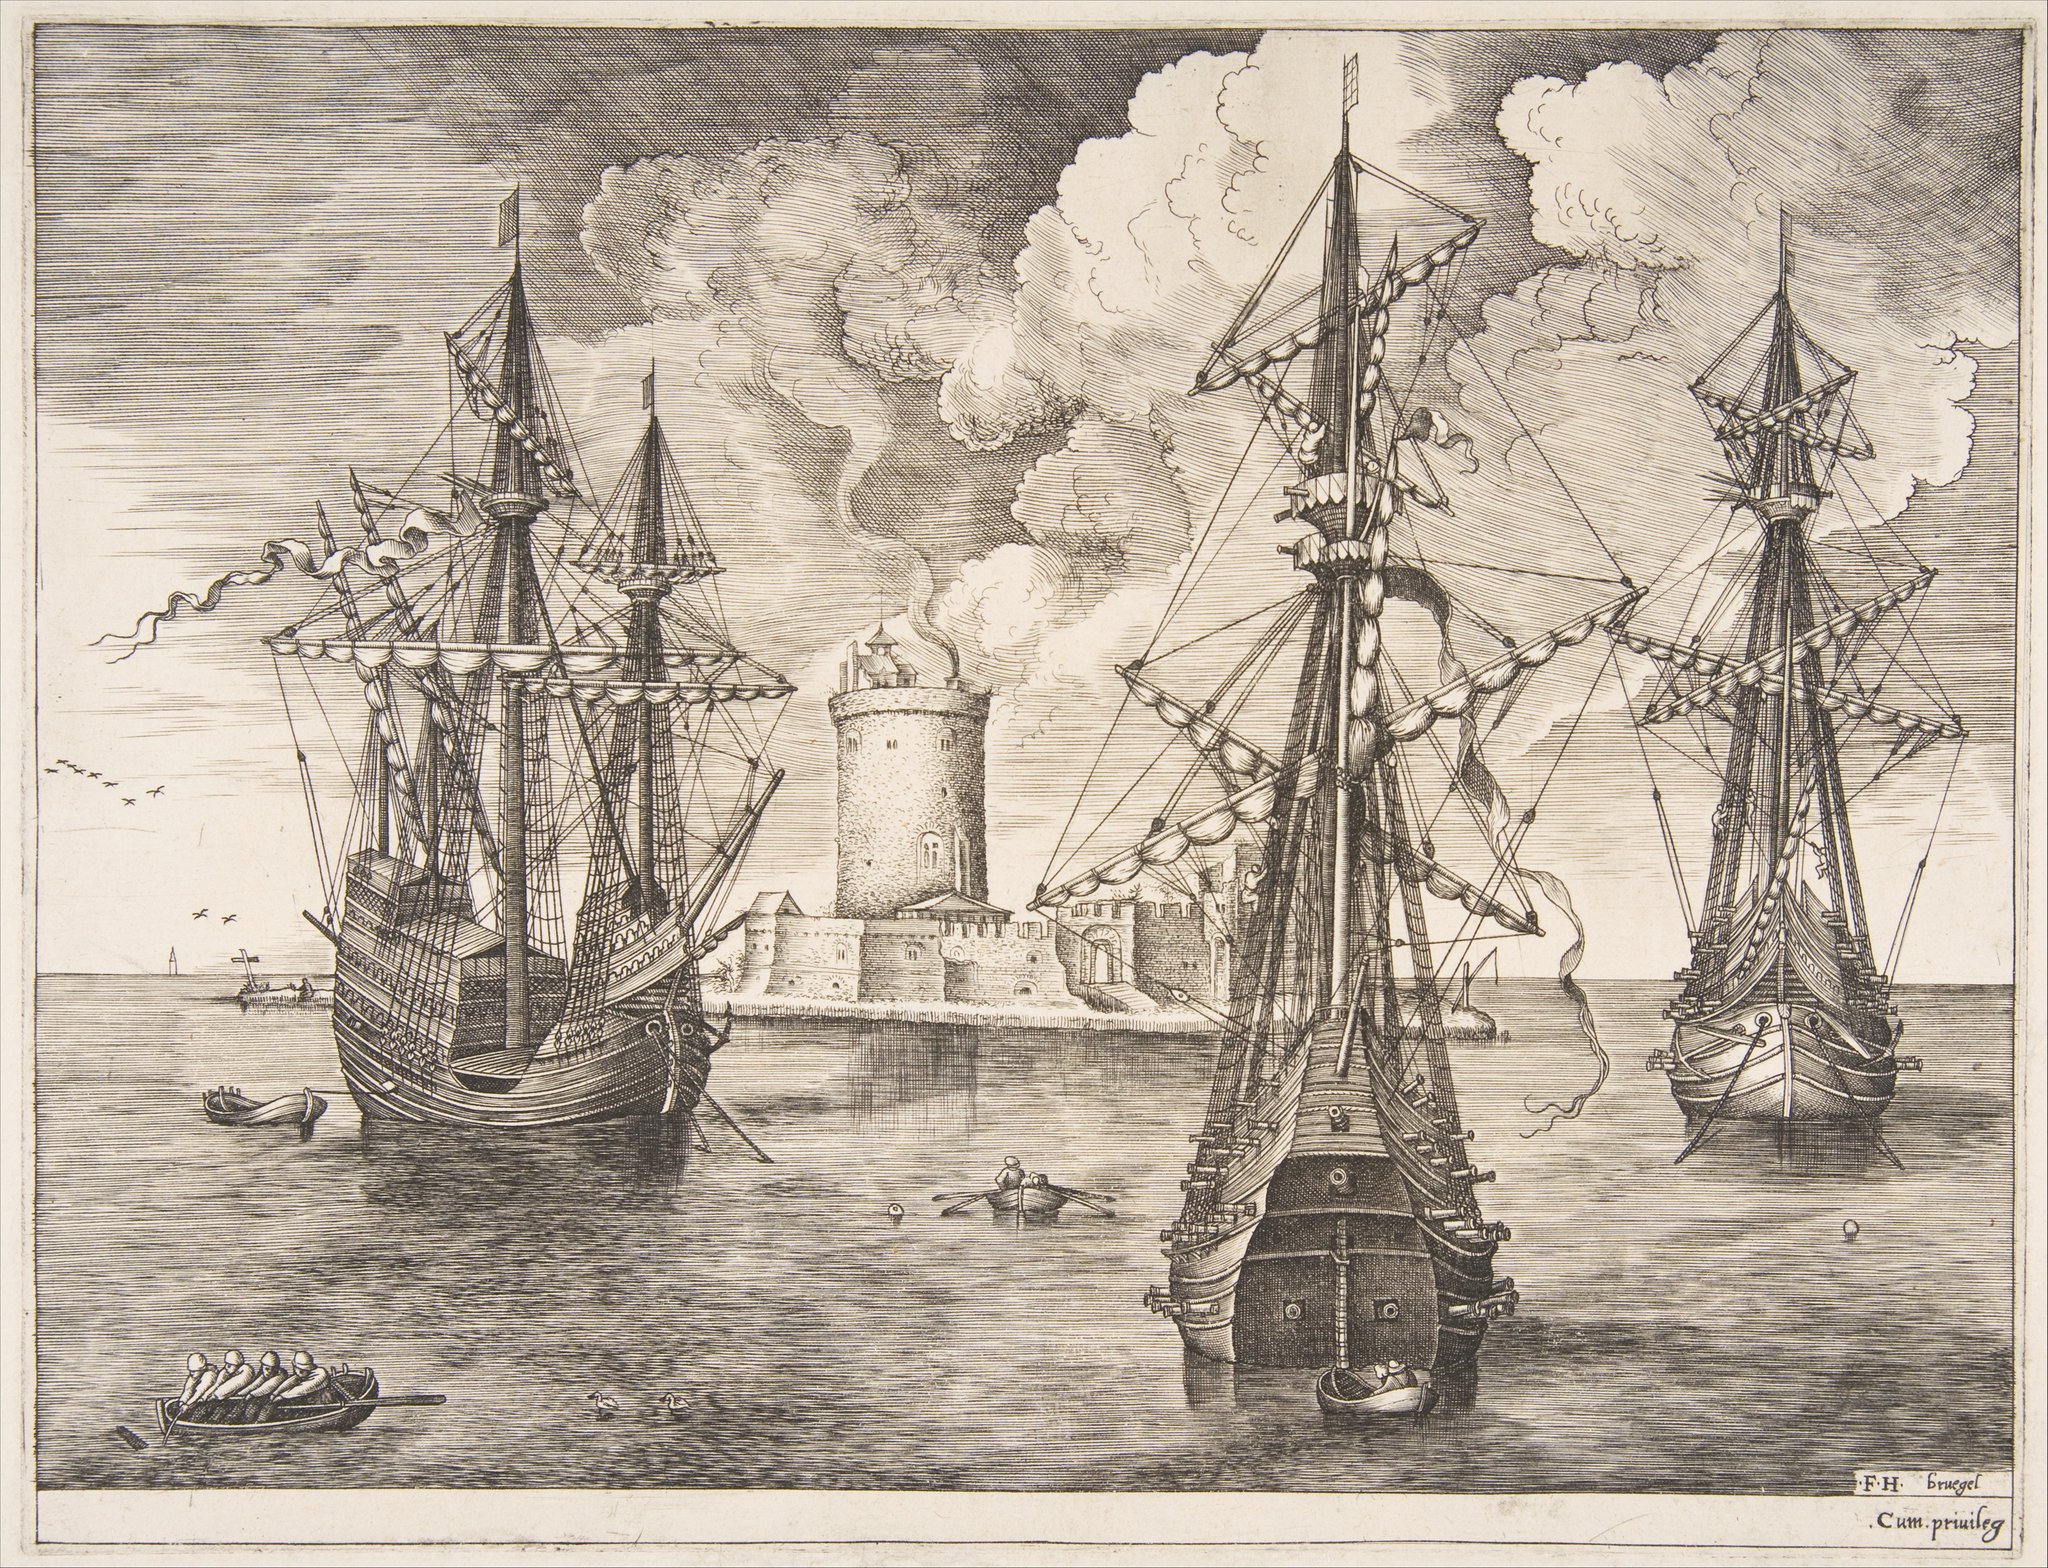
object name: print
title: Four-master and Two Three-masters Anchored near a Fortified Island, from "The Sailing Vessels"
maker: pieter bruegel the elder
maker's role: artist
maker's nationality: netherlandish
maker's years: 1525-1569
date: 1561-1565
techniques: engraving, etching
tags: boats,ships